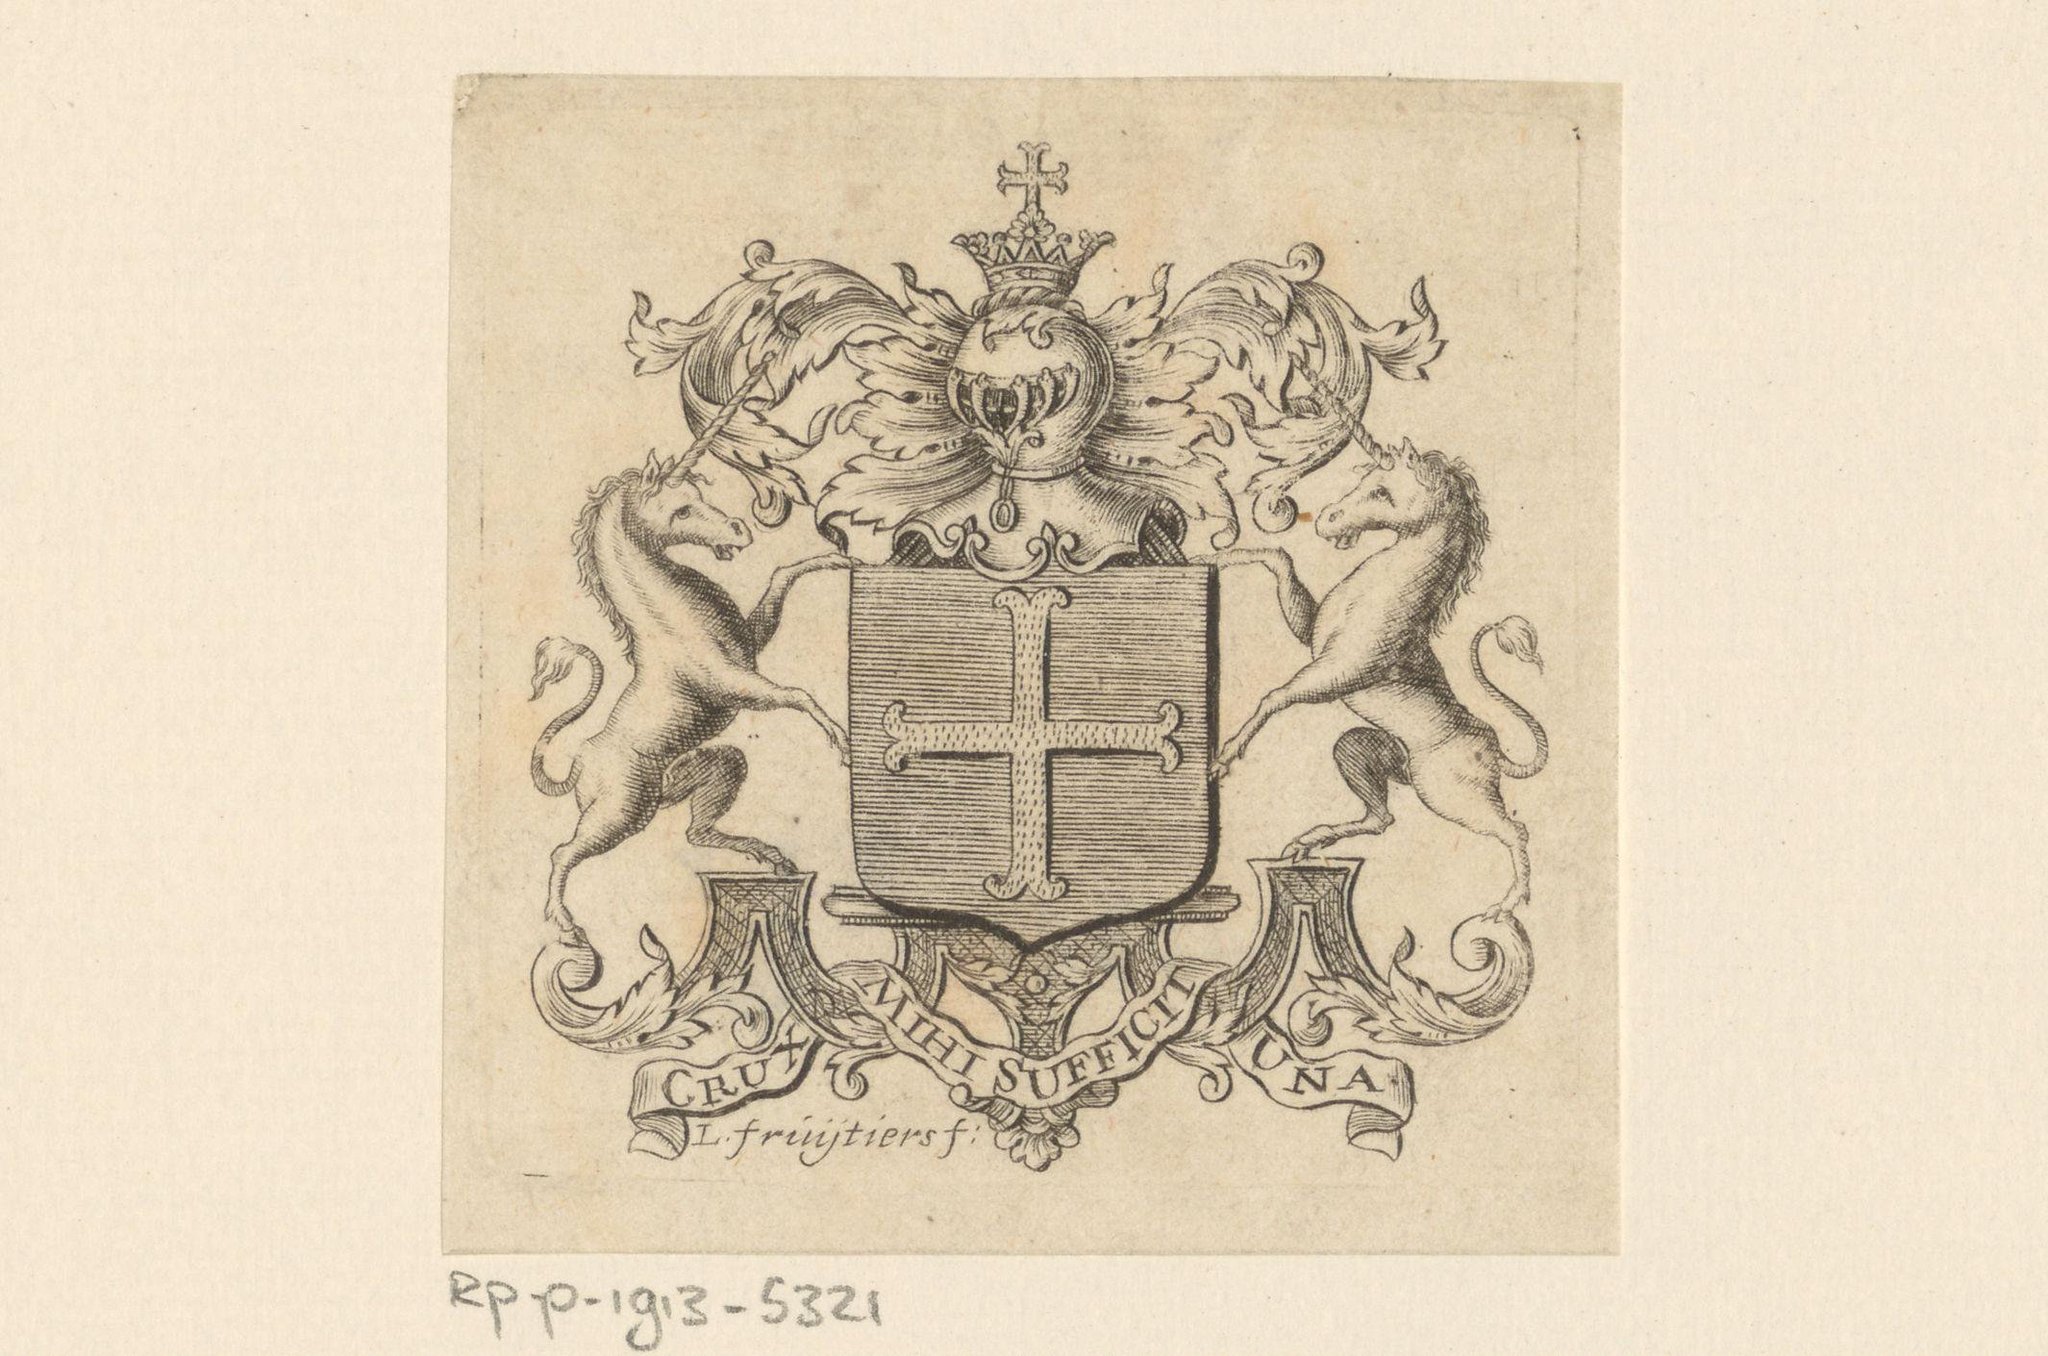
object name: bookplate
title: Ex libris van onbekend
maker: lodewijk joseph fruytiers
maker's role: print maker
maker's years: 1713-1782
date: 1723-1782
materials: paper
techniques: engraving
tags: armorial bearing, heraldry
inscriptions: collector's mark: Lugt 2760, collector's mark: Lugt 2233